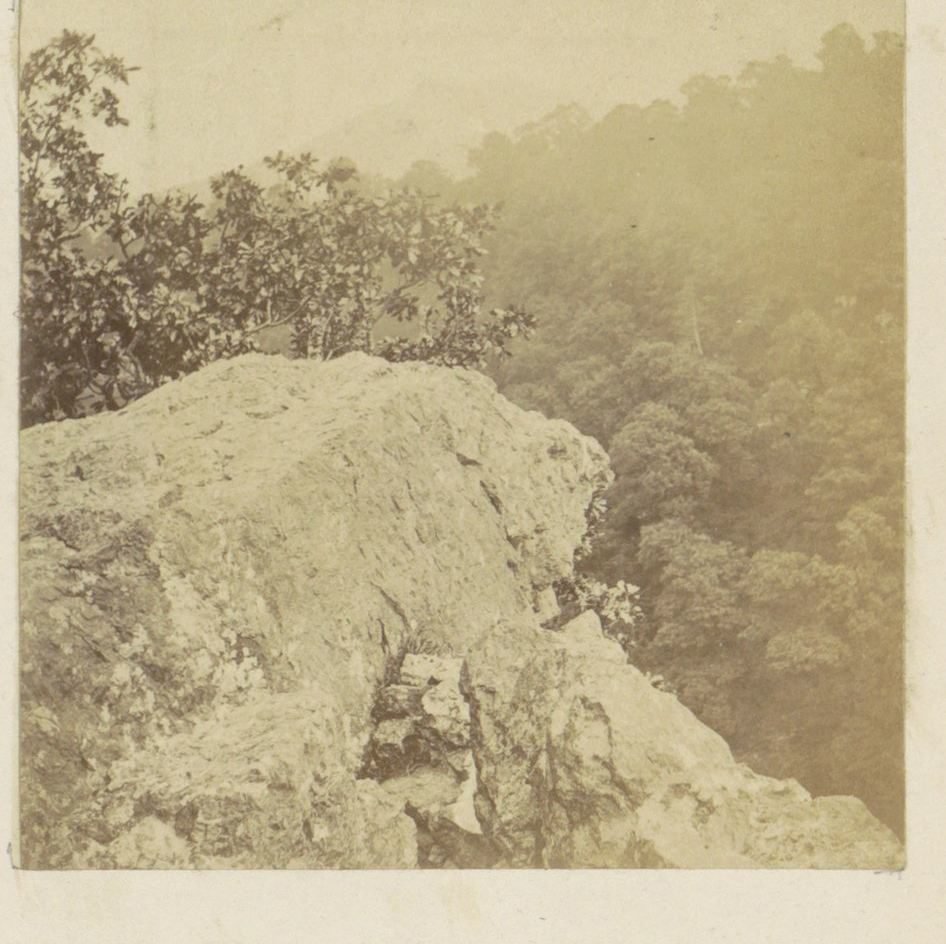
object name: photograph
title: Rotsformatie in Engeland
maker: Anonymous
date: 1850-1870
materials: paper, photographic support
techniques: albumen print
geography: england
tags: rock-formations, england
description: Onderdeel van Album met foto's van bezienswaardigheden en landschappen in Engeland en van kunst.